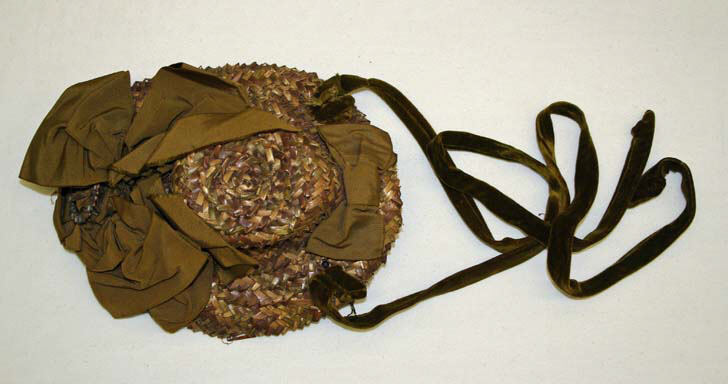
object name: hat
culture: american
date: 1875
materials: silk, fiber